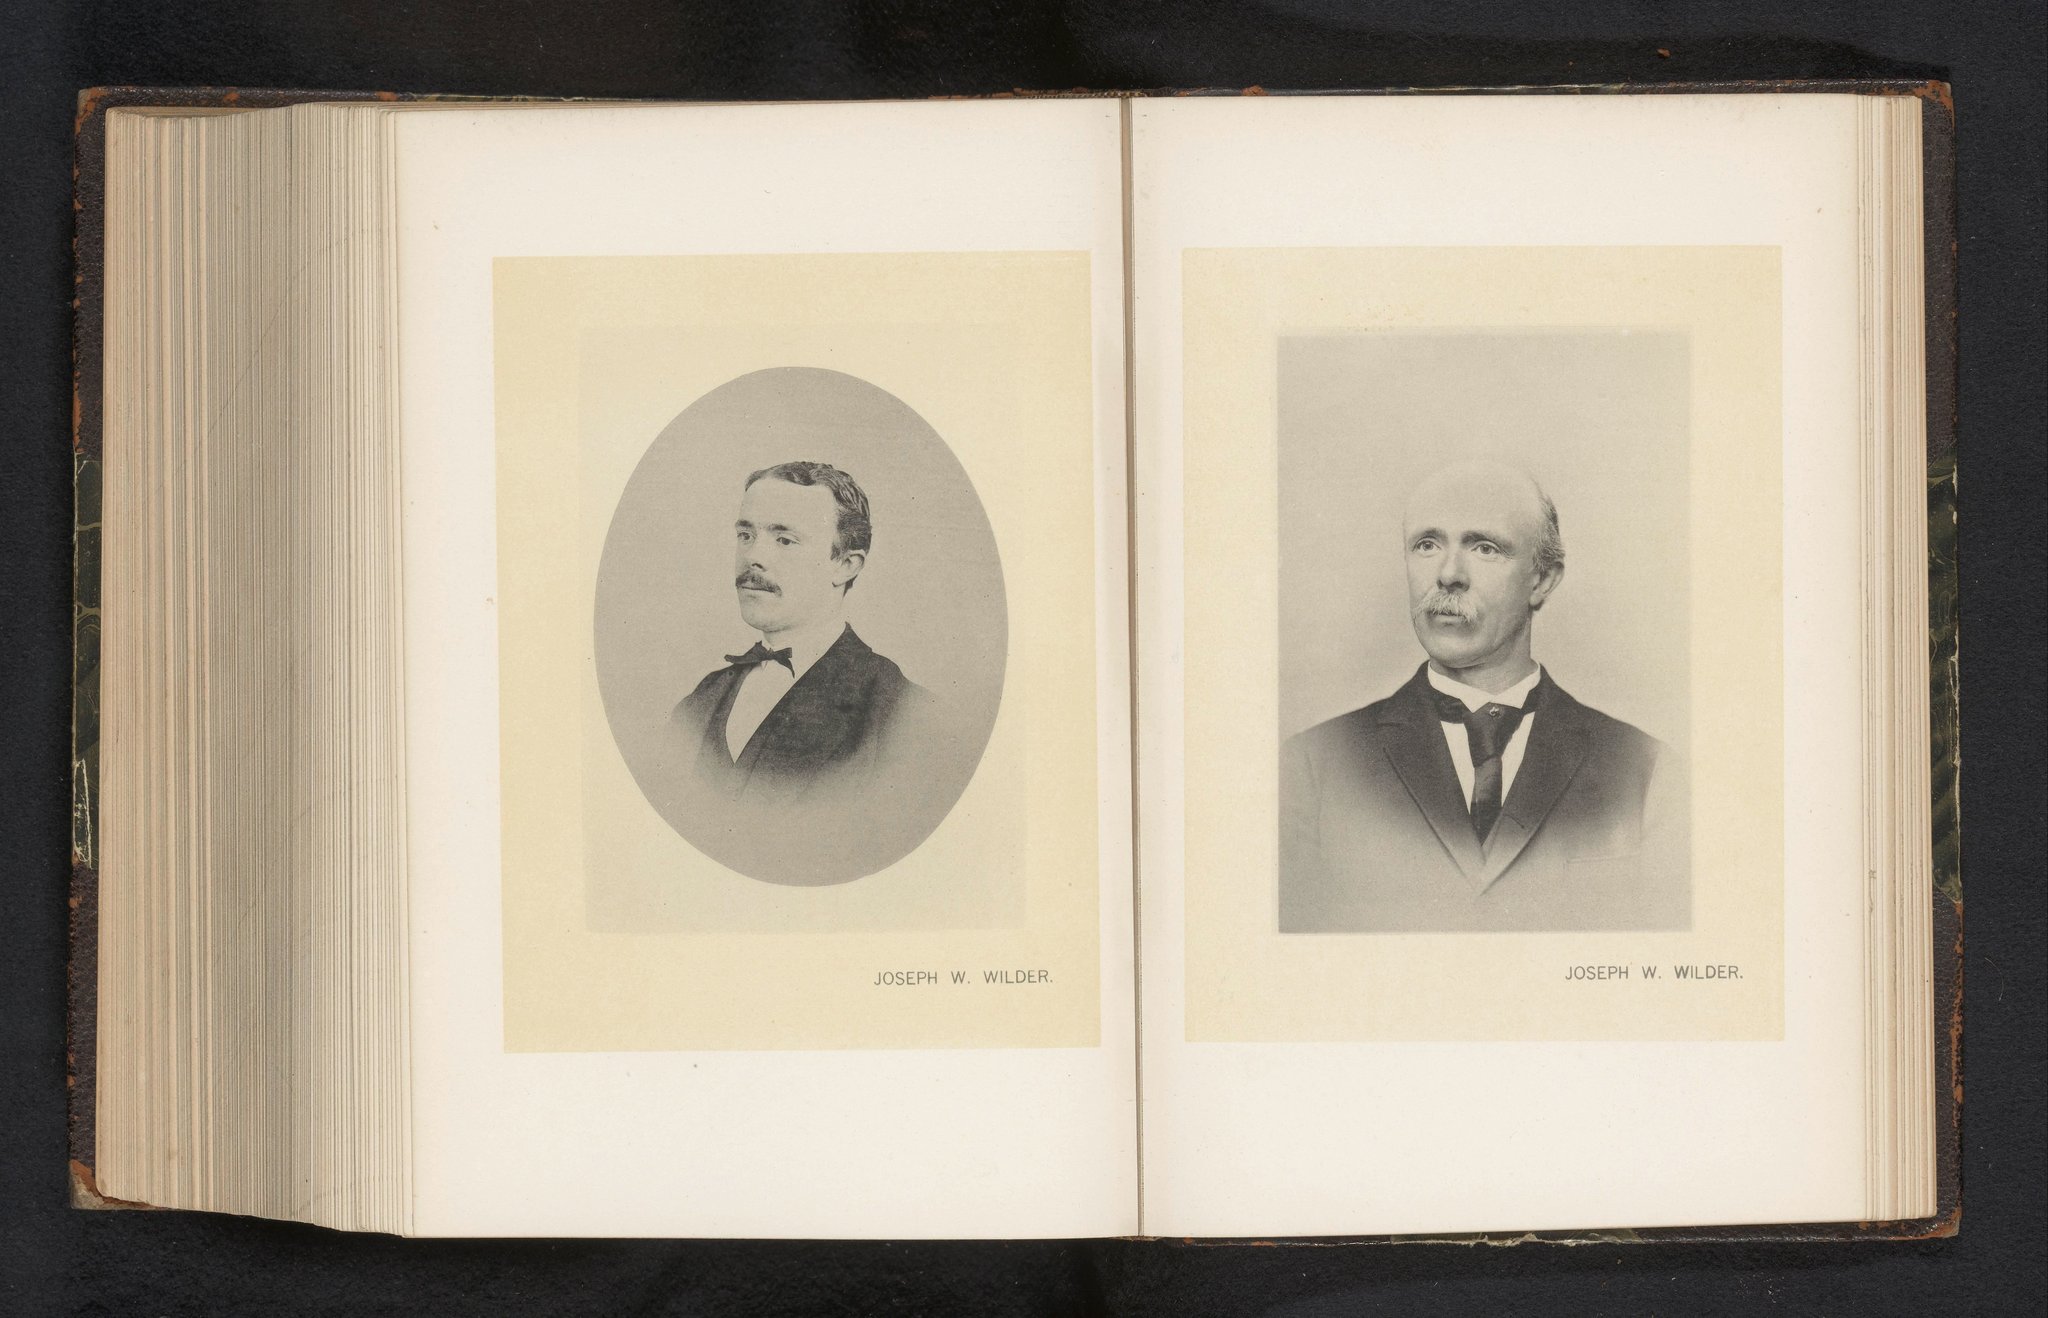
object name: photomechanical print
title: Joseph W. Wilder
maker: Anonymous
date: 1889-1894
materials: paper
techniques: photoaquatint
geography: boston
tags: adult man